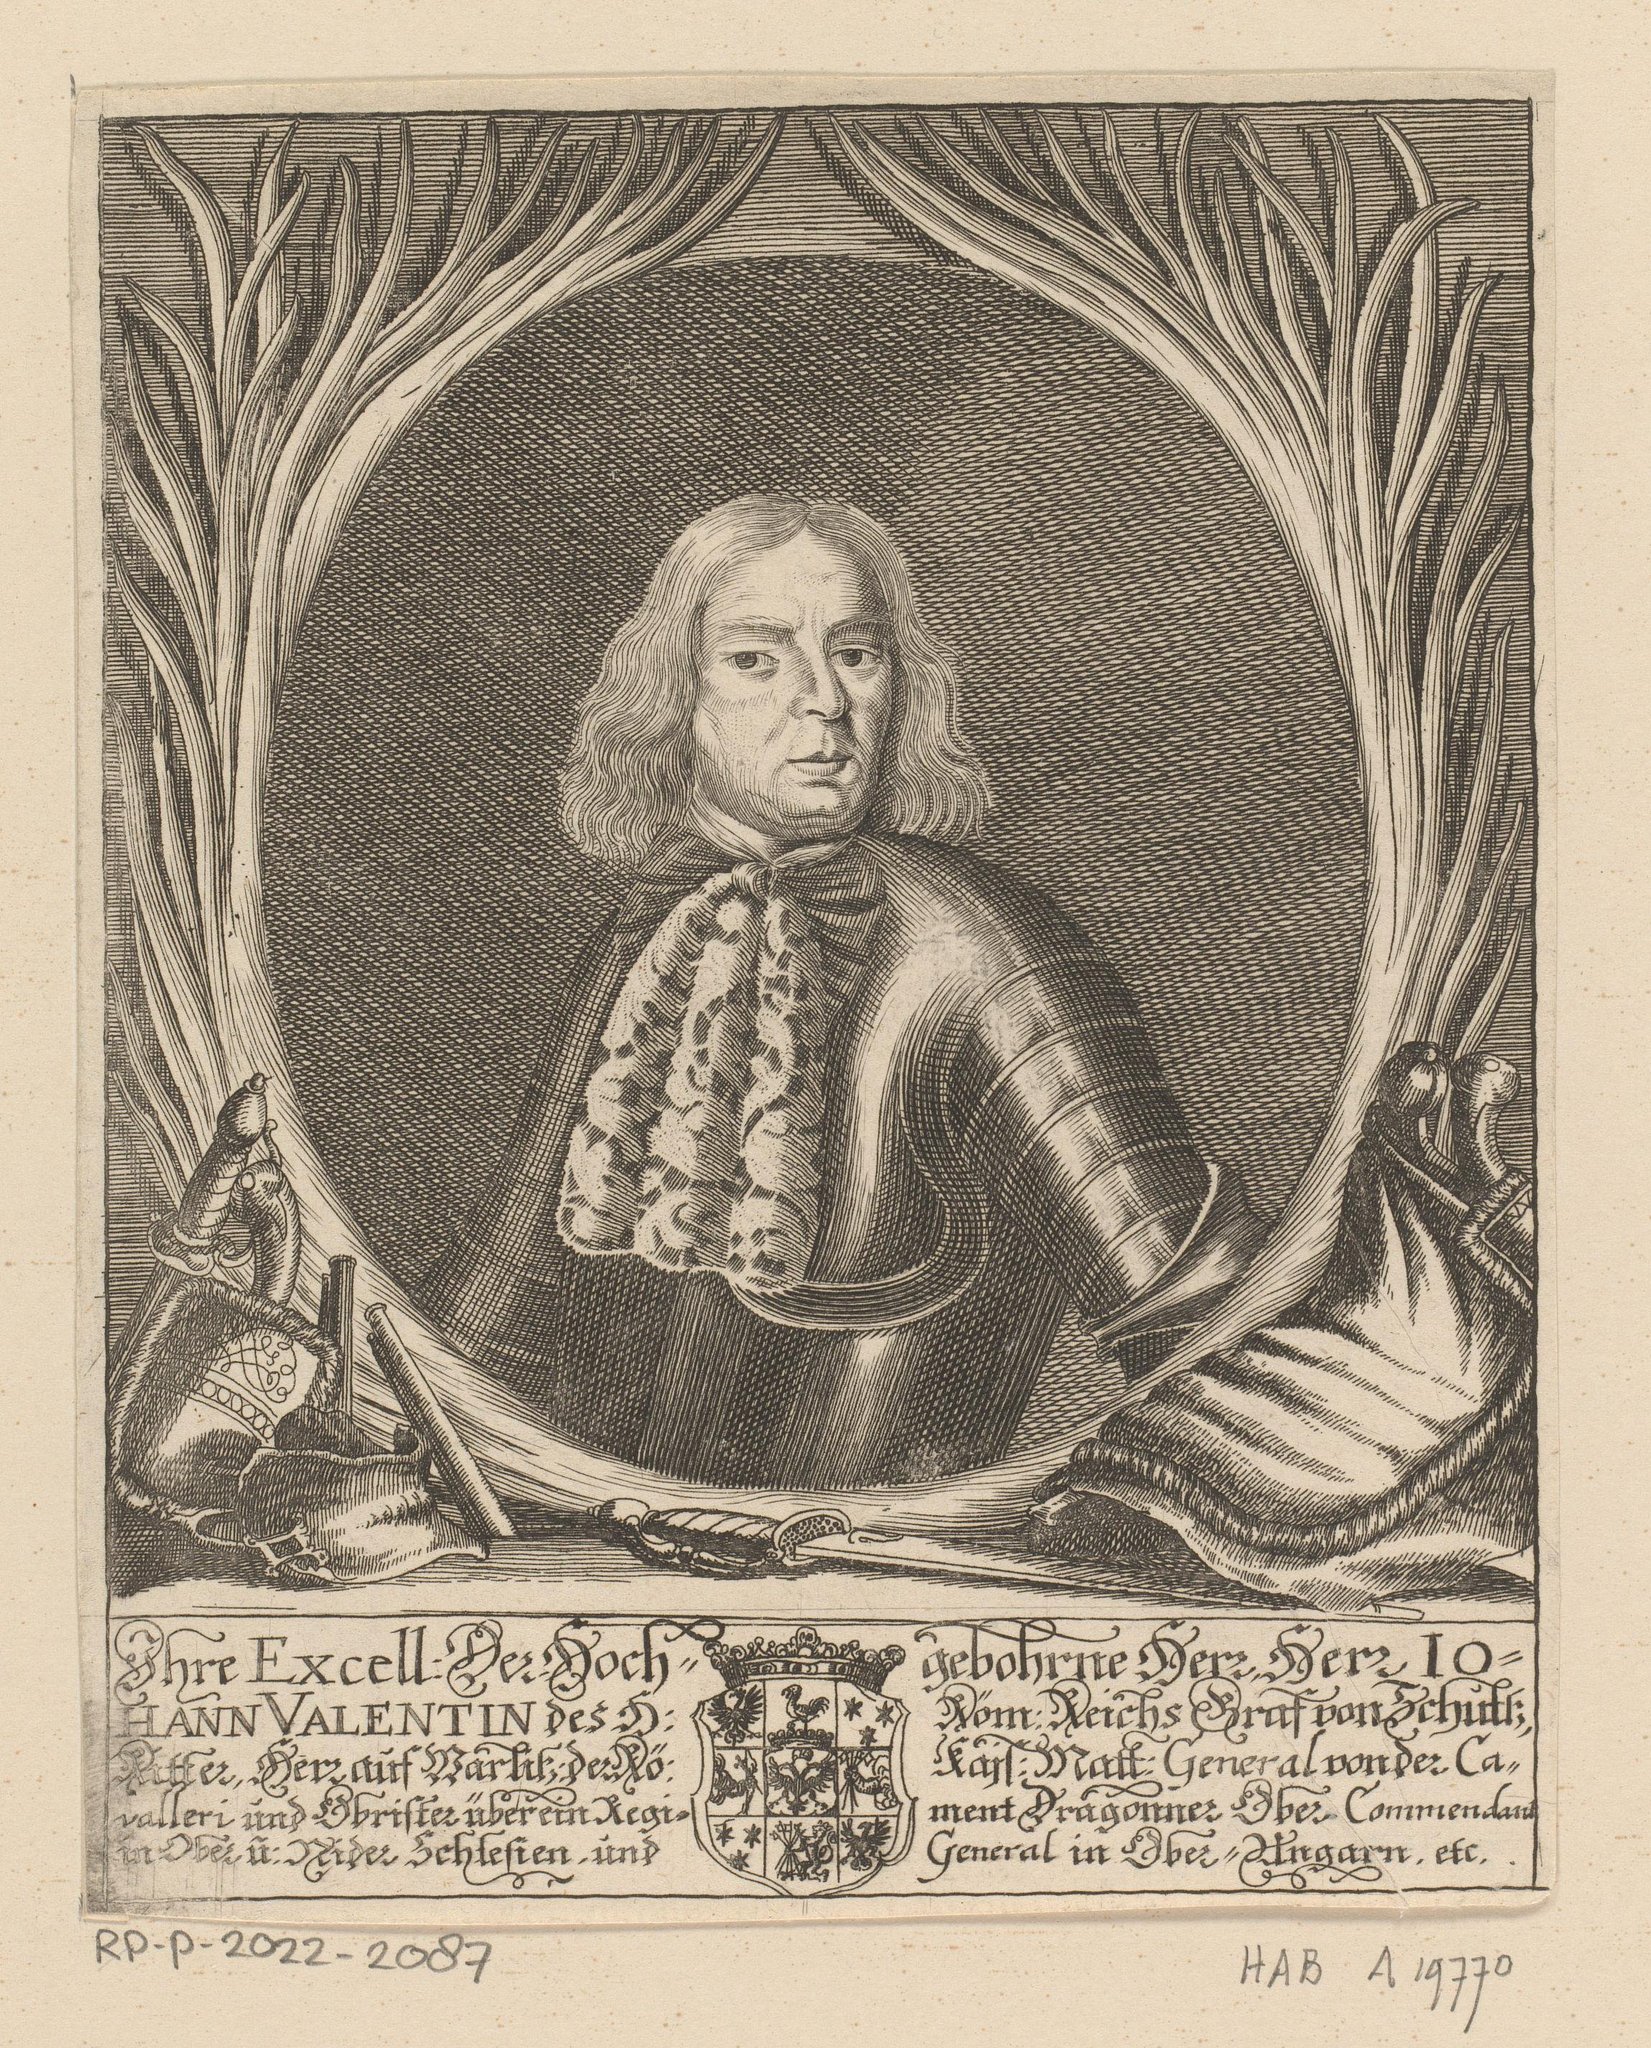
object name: print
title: Portret van Johann Valentin von Schultz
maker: Anonymous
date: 1688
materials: paper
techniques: engraving, etching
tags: commander-in-chief, general, marshal, historical persons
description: Prent waarschijnlijk uit: Boethius, Christoph. Des Ruhm-belorberten und Triumph-leuchtenden Kriegs-Helms Dero Röm. Kais.Maj. und Dero Hohen Bunds-Verwandten, Wider den Mahometischen Tulband (...). Neurenberg: Johann Christoph Lochner, 1688.